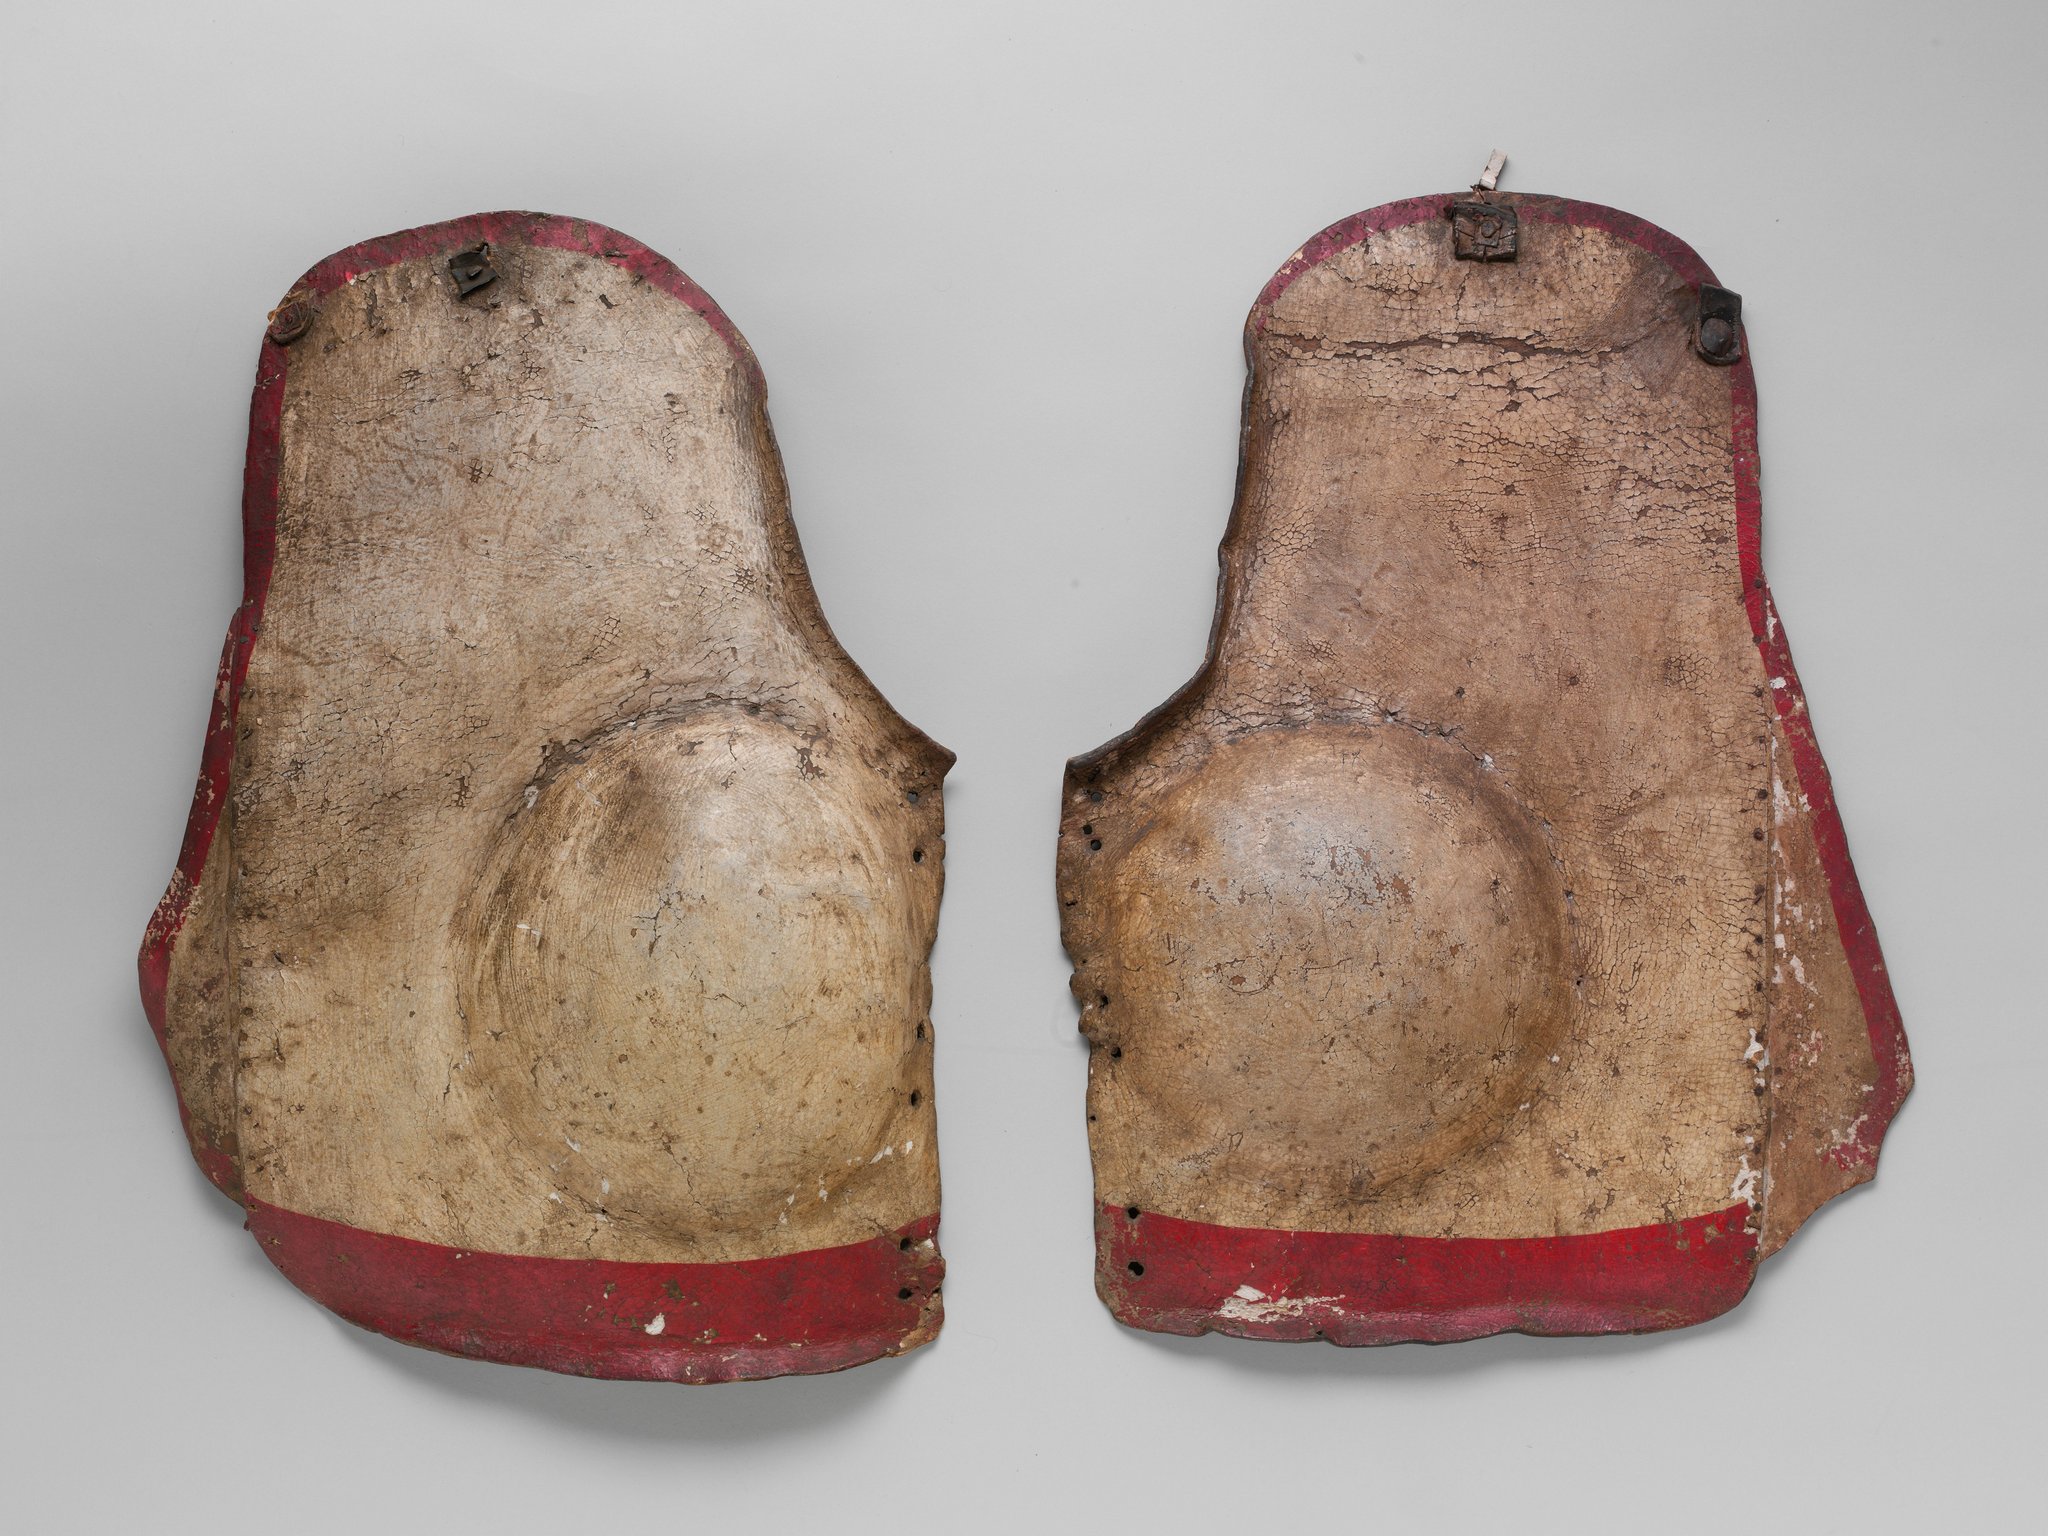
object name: peytral plate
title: Peytral Plates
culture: flemish or german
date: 1501-1533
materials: gesso, leather, metal